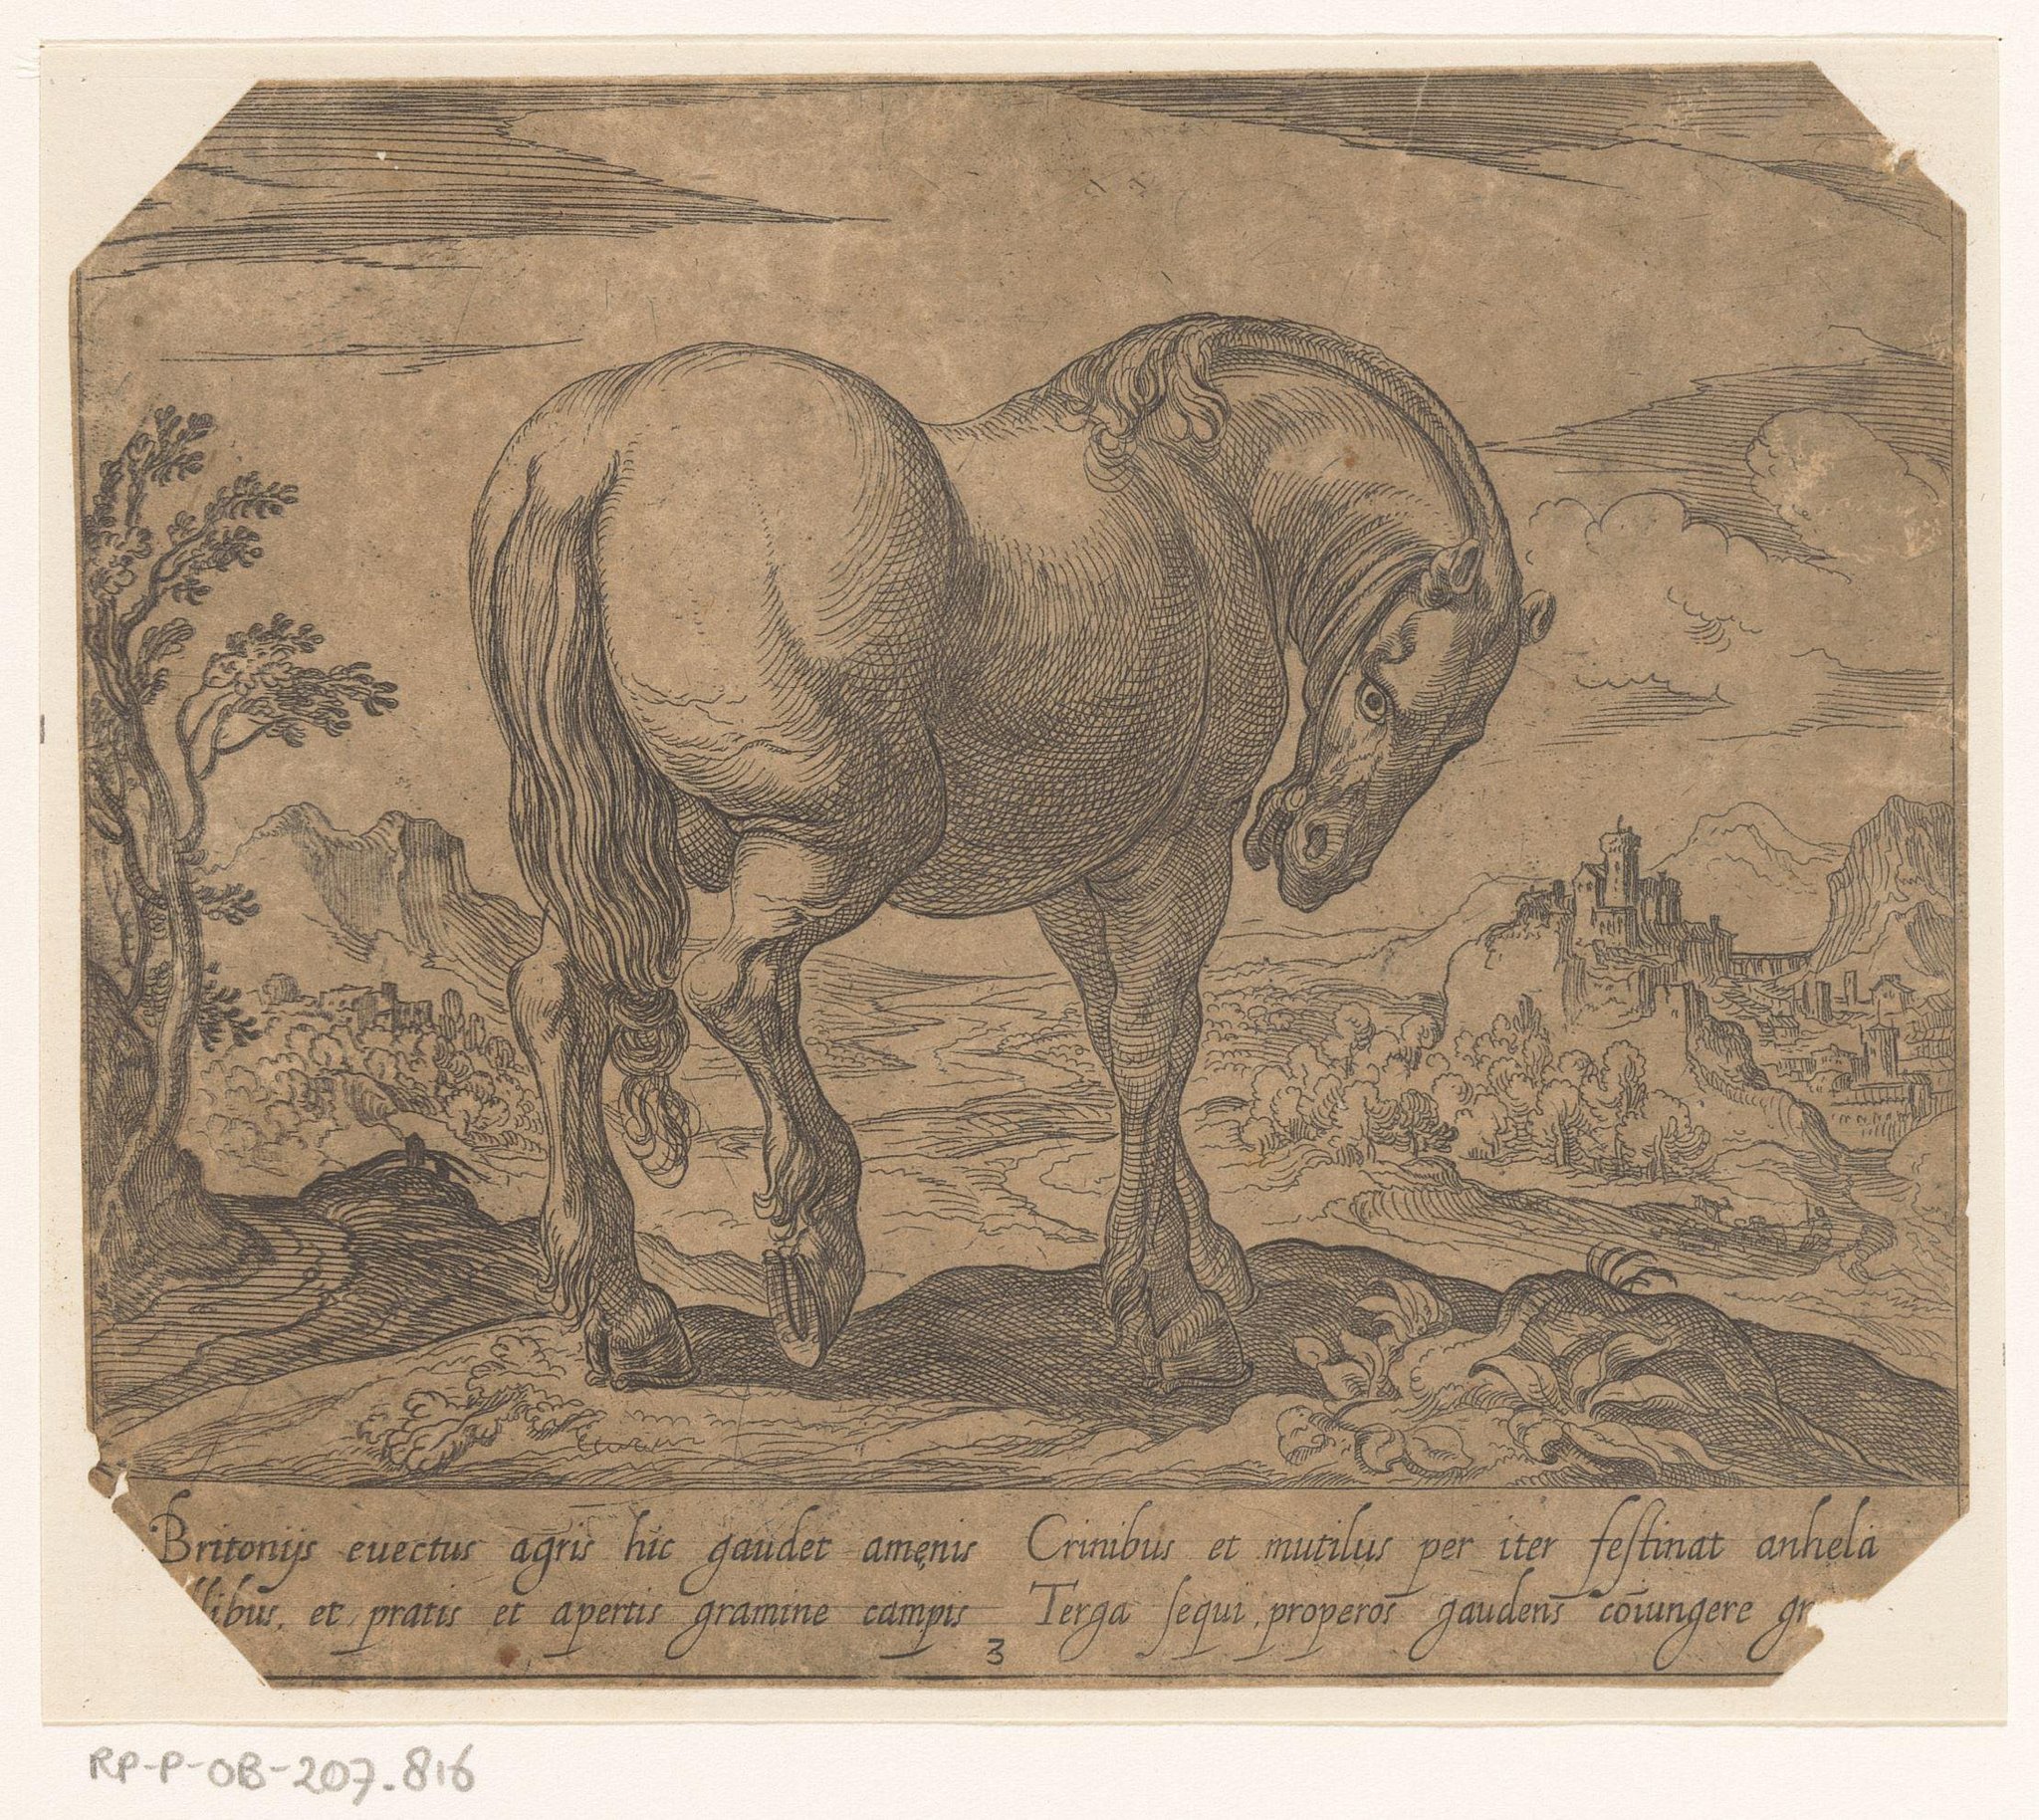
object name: print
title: His ducibus princeps celebraberis ore viroru illa homines beat haec sideribusq locat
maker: antonio tempesta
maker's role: draughtsman, painter, print maker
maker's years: 1555-1630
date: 1590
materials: paper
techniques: etching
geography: italy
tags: horse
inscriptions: collector's mark: Lugt 2228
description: Deze prent maakt deel uit van een reeks van 28 prenten van paarden (+ titelprent en opdracht).